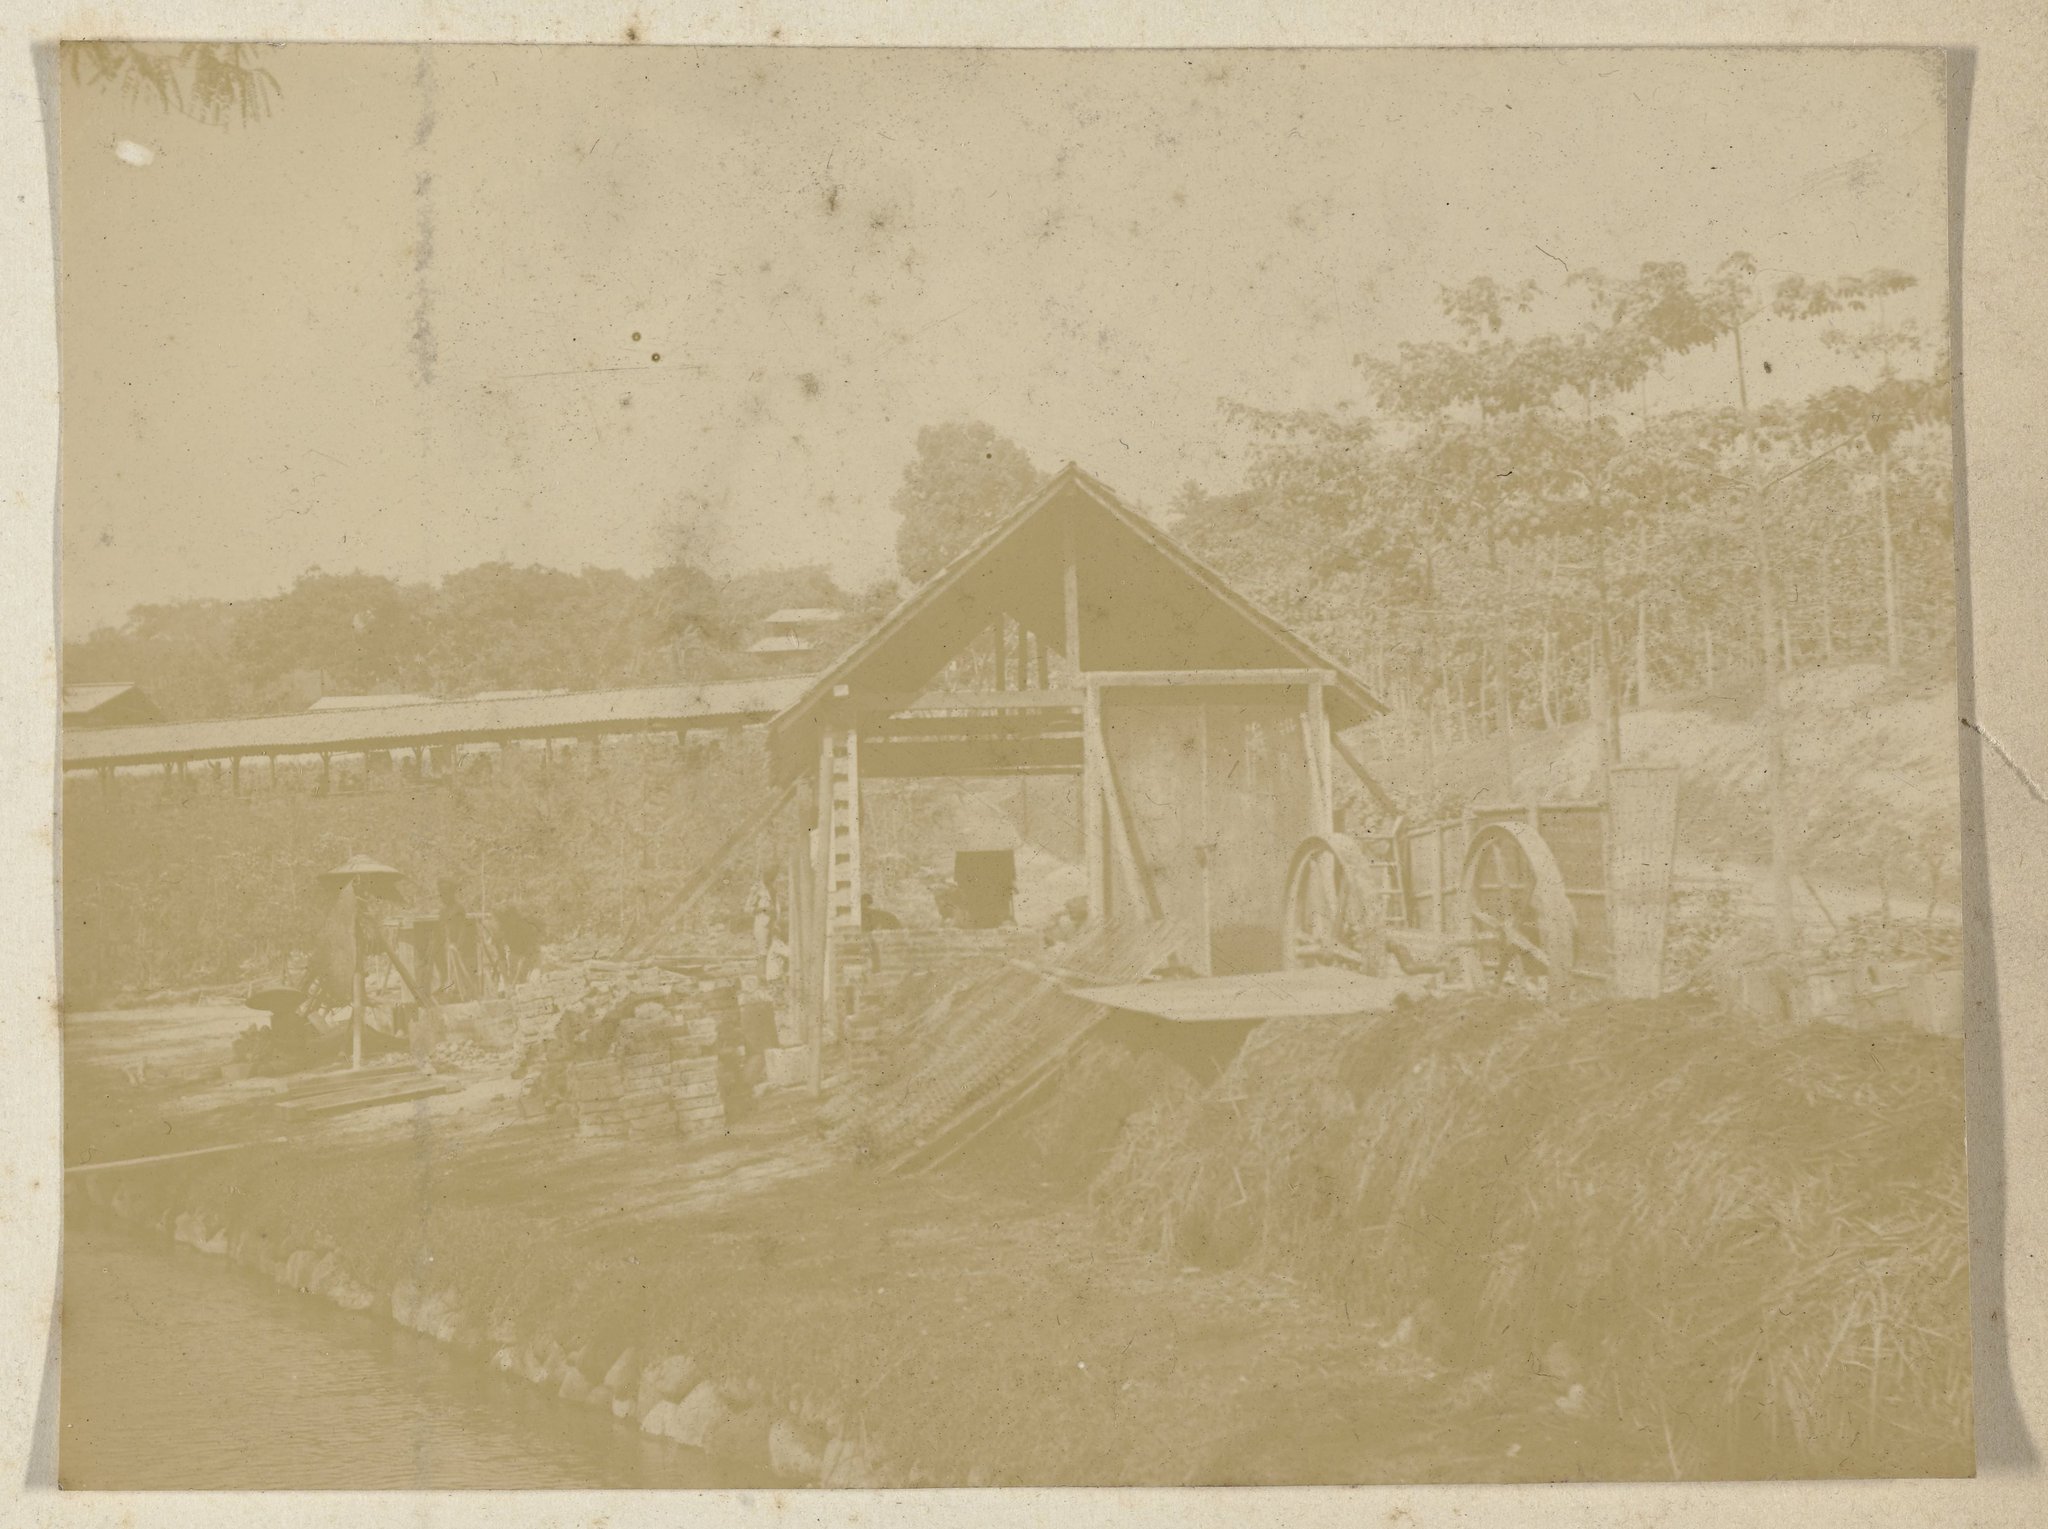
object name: photograph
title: 5 kiekjes te Djattie roenggo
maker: Anonymous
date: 1890-1910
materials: cardboard, paper, photographic support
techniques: gelatin silver print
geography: netherlands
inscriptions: caption: ‘5 kiekjes te Djattie roenggo’